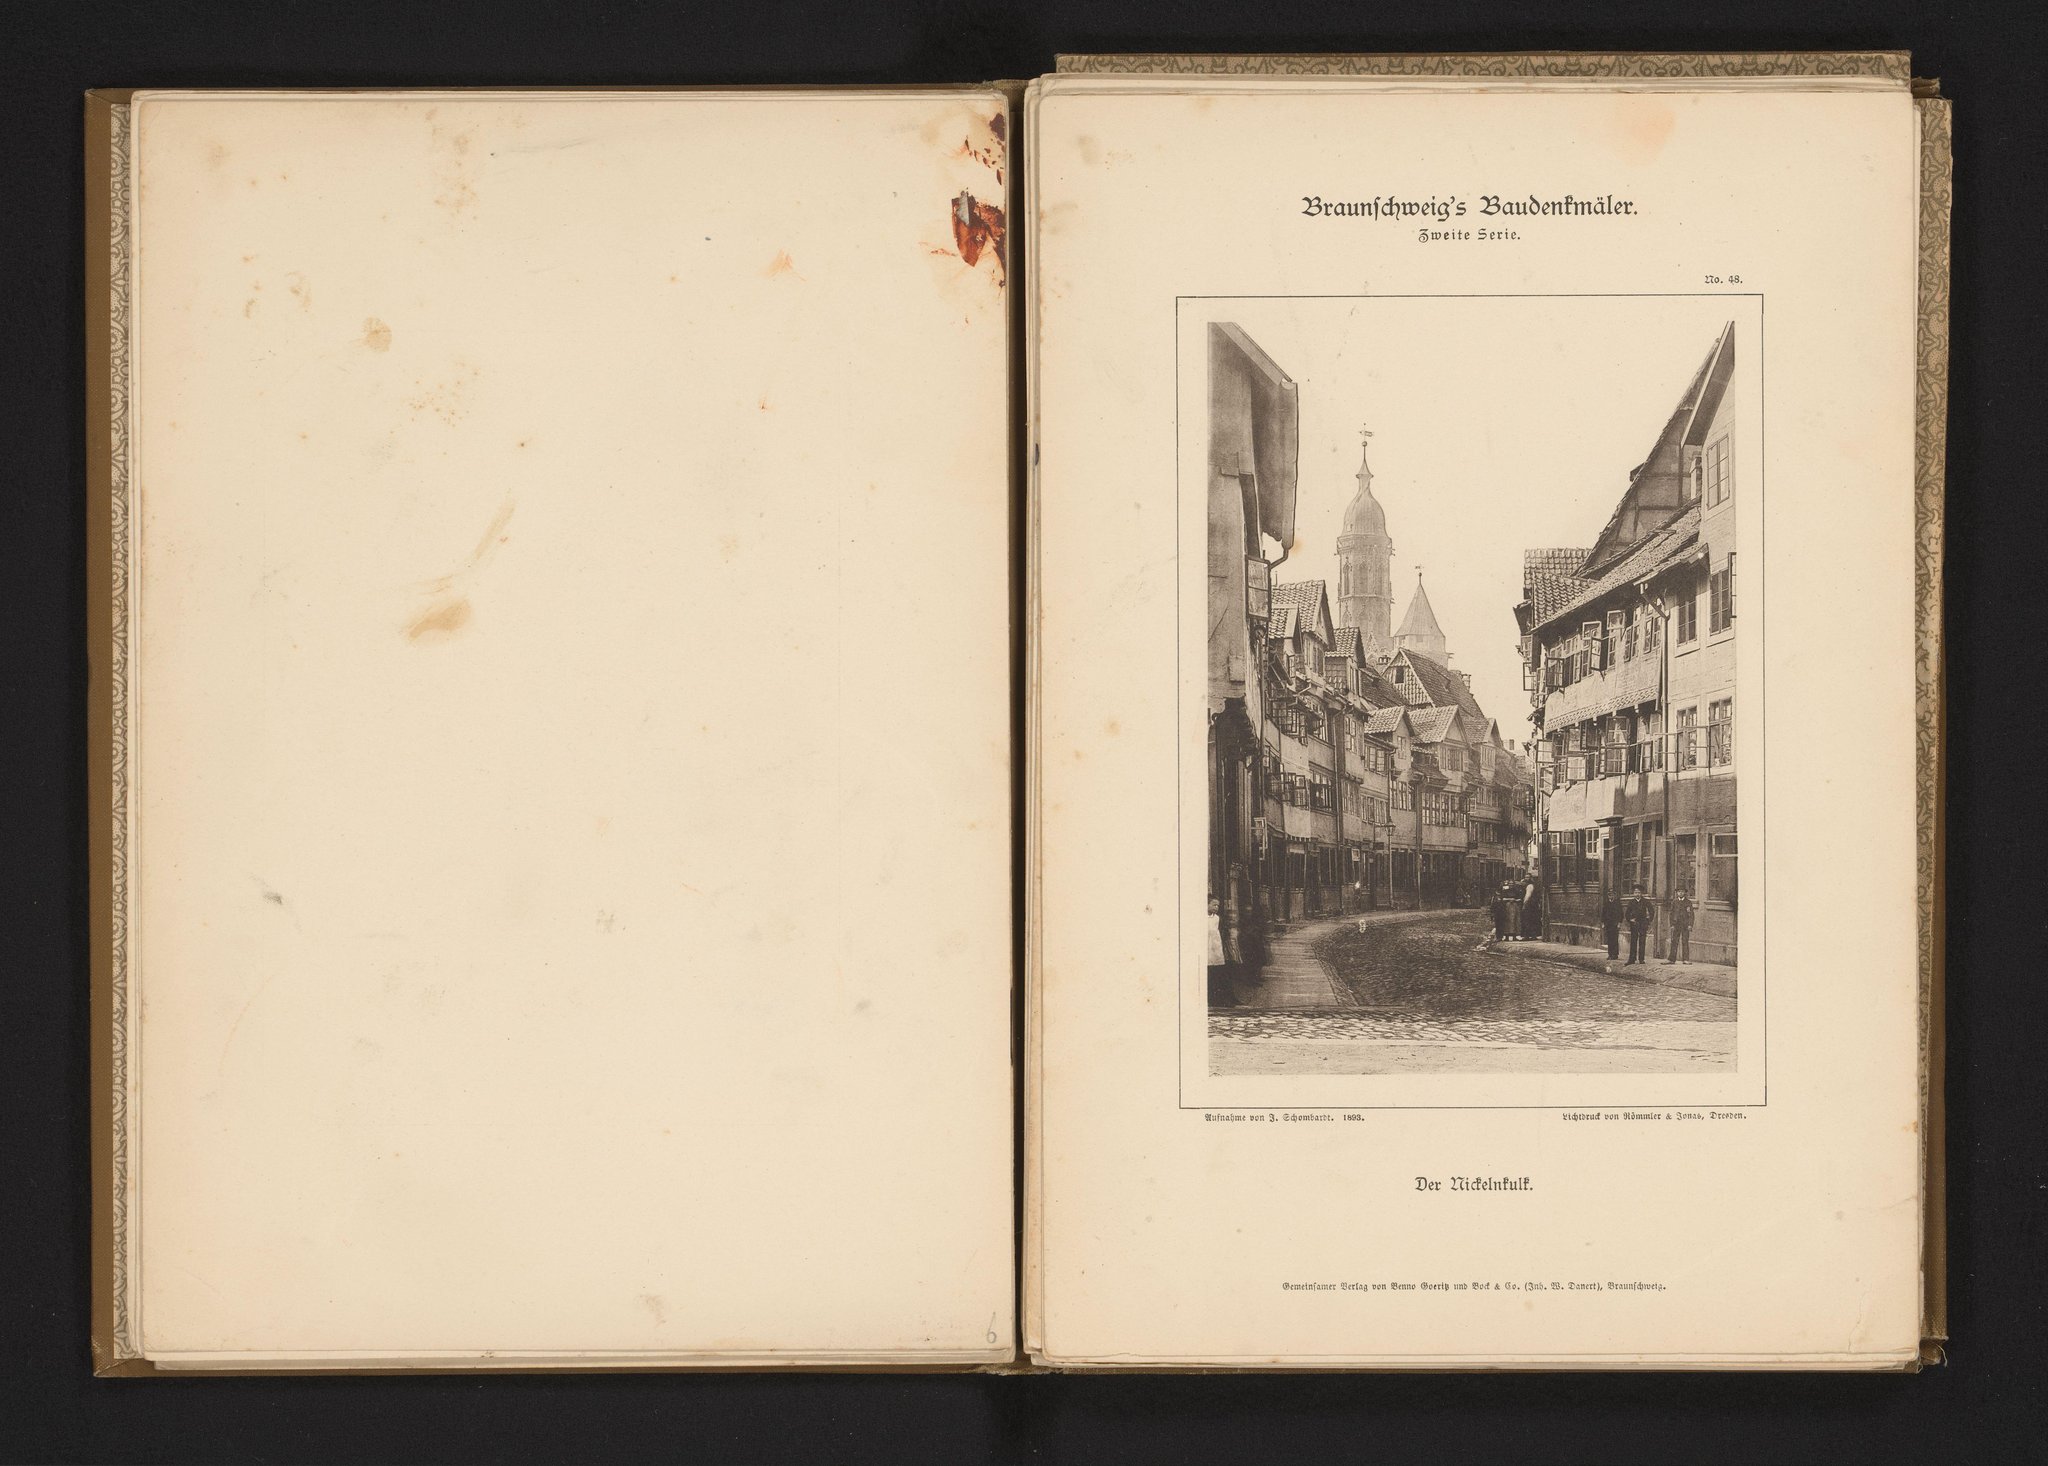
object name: page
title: Der Nickelnkulk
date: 1893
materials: paper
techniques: photograph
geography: braunschweig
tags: façade (of house or building)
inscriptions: number: ‘No. 48.’